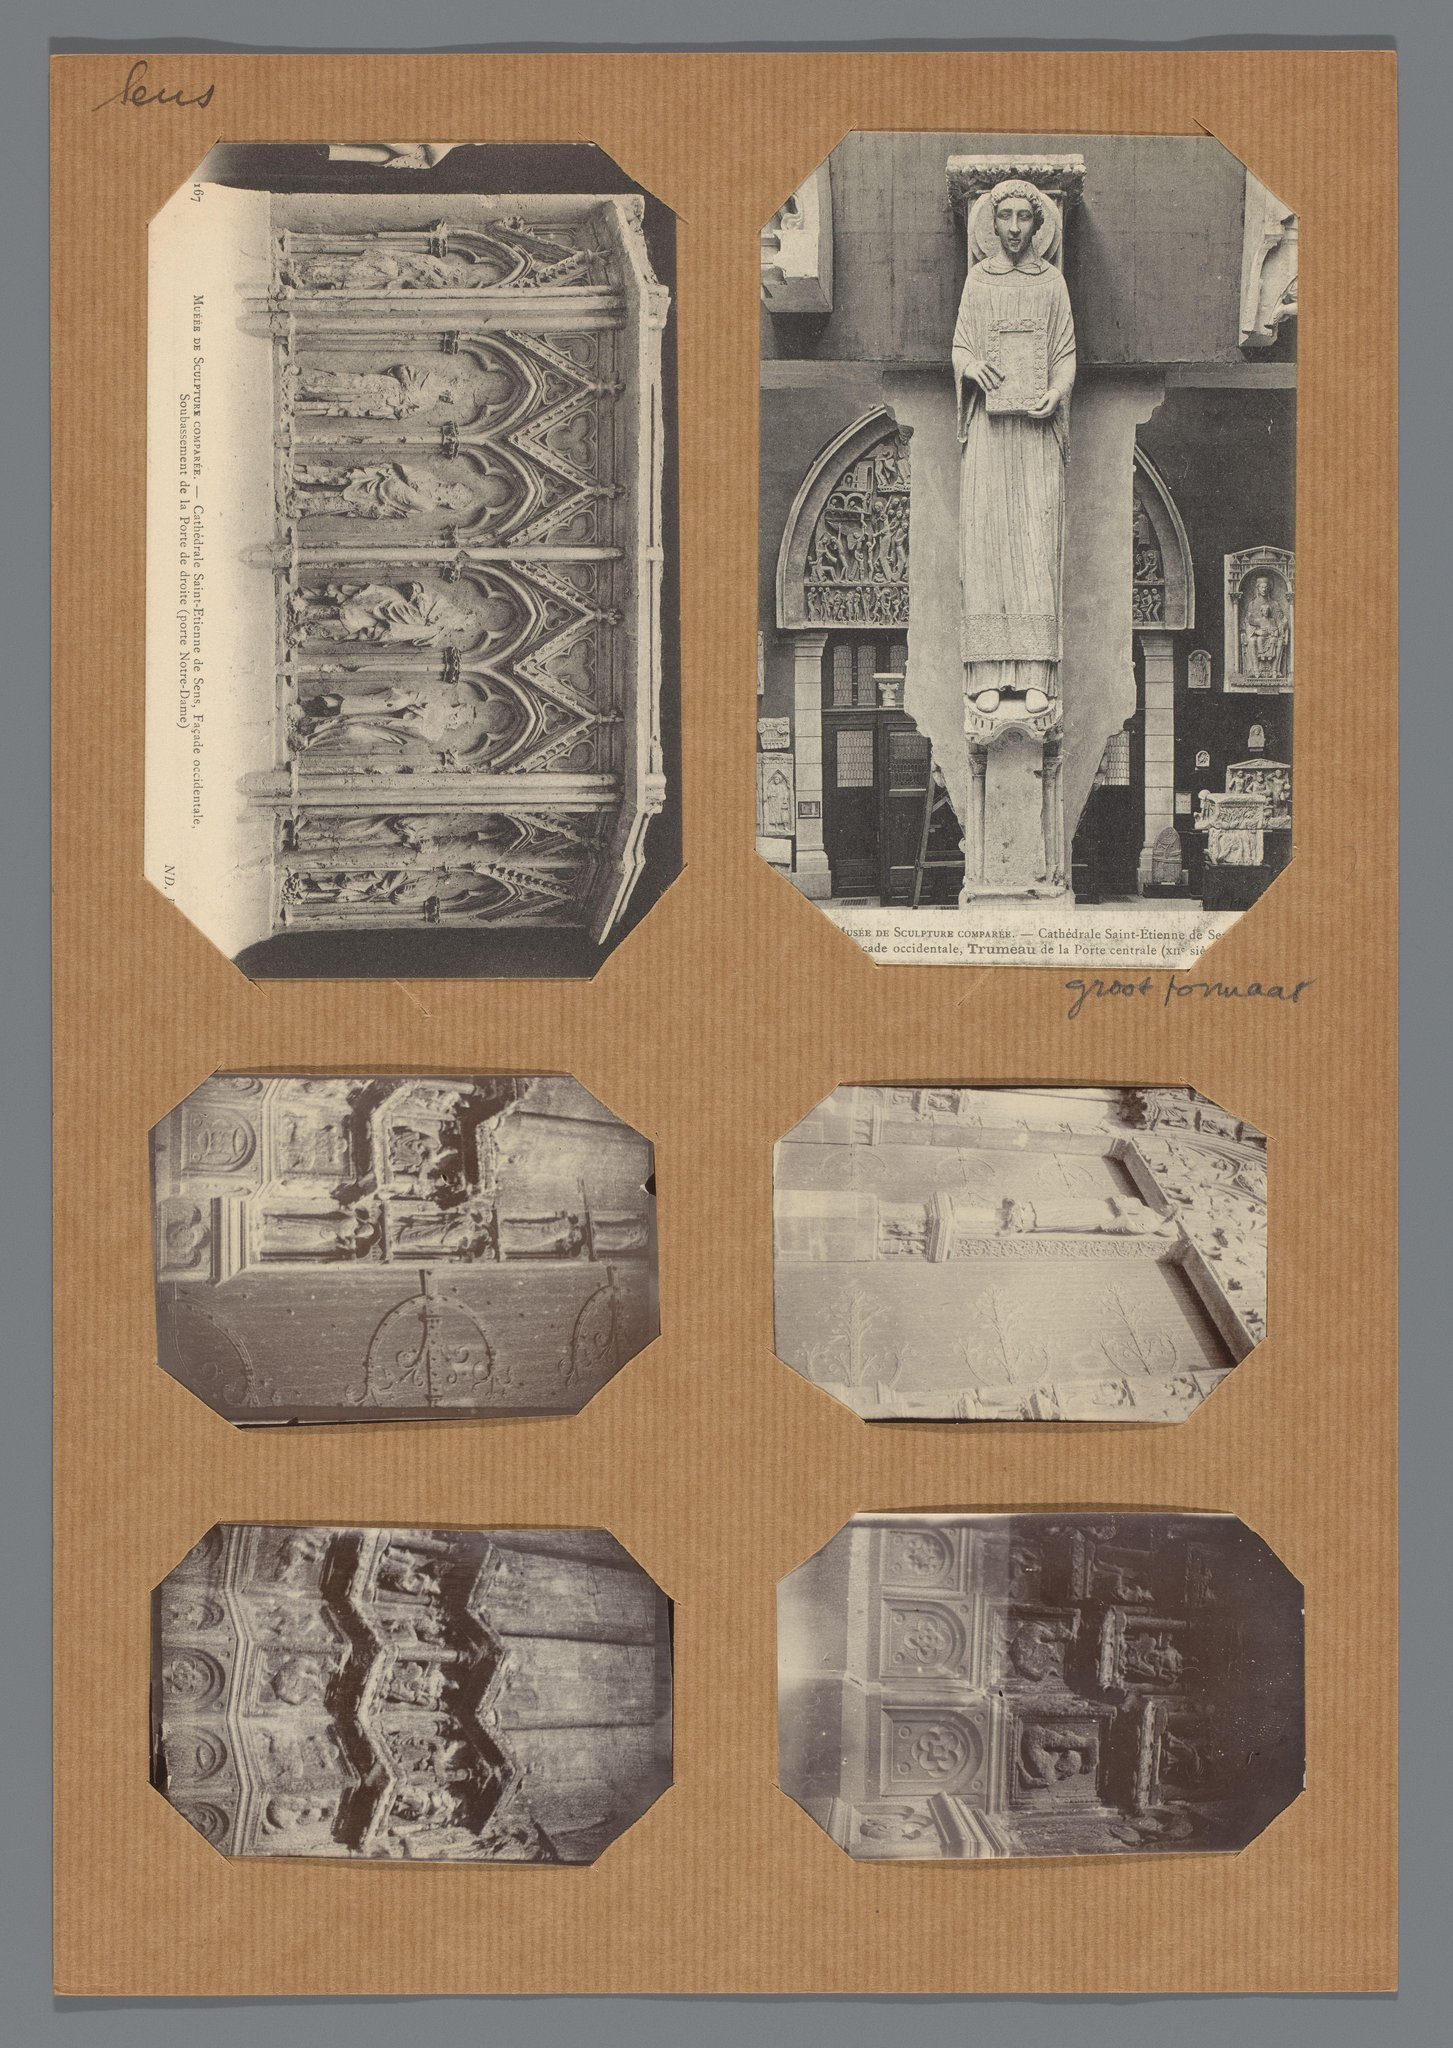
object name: photograph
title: Sens. Cathédrale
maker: Anonymous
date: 1880-1930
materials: photographic support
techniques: gelatin silver print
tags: kathedraal van sens